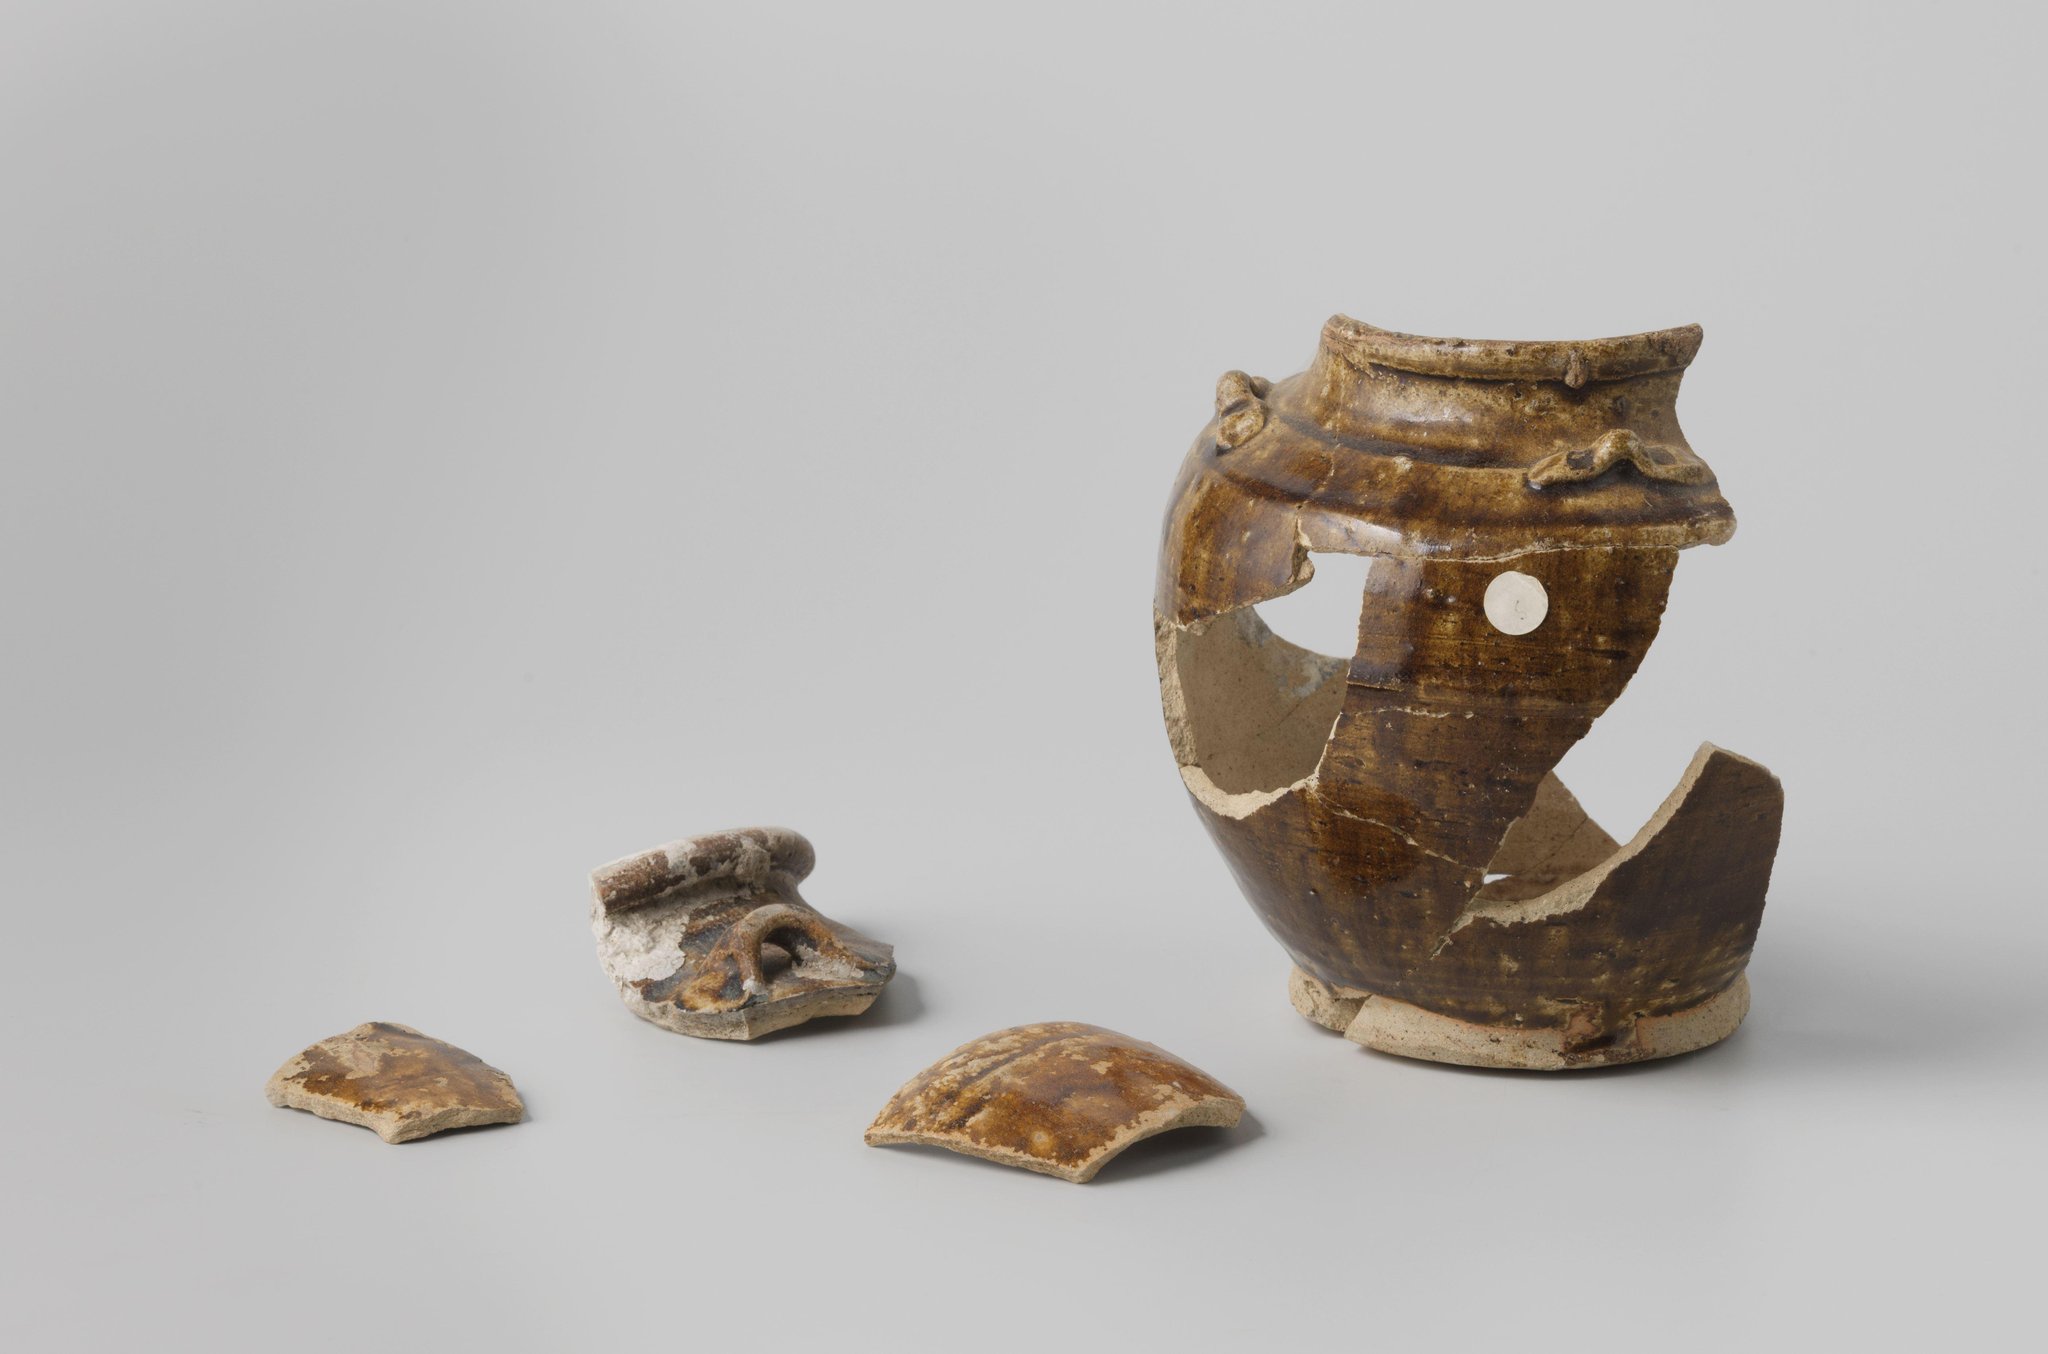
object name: martavaan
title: Scherven van martavanen uit V.O.C.-schip de 'Witte Leeuw'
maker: Anonymous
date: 1613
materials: glaze, porcelain, stoneware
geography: guangdong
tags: verenigde oostindische compagnie, sint-helena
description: A jar. The outside is covered with a glossy, olive green glaze. The base is unglazed. The inside of the lip and neck is glazed. There are drops of glaze at the junction of the shoulder and on the bottom.